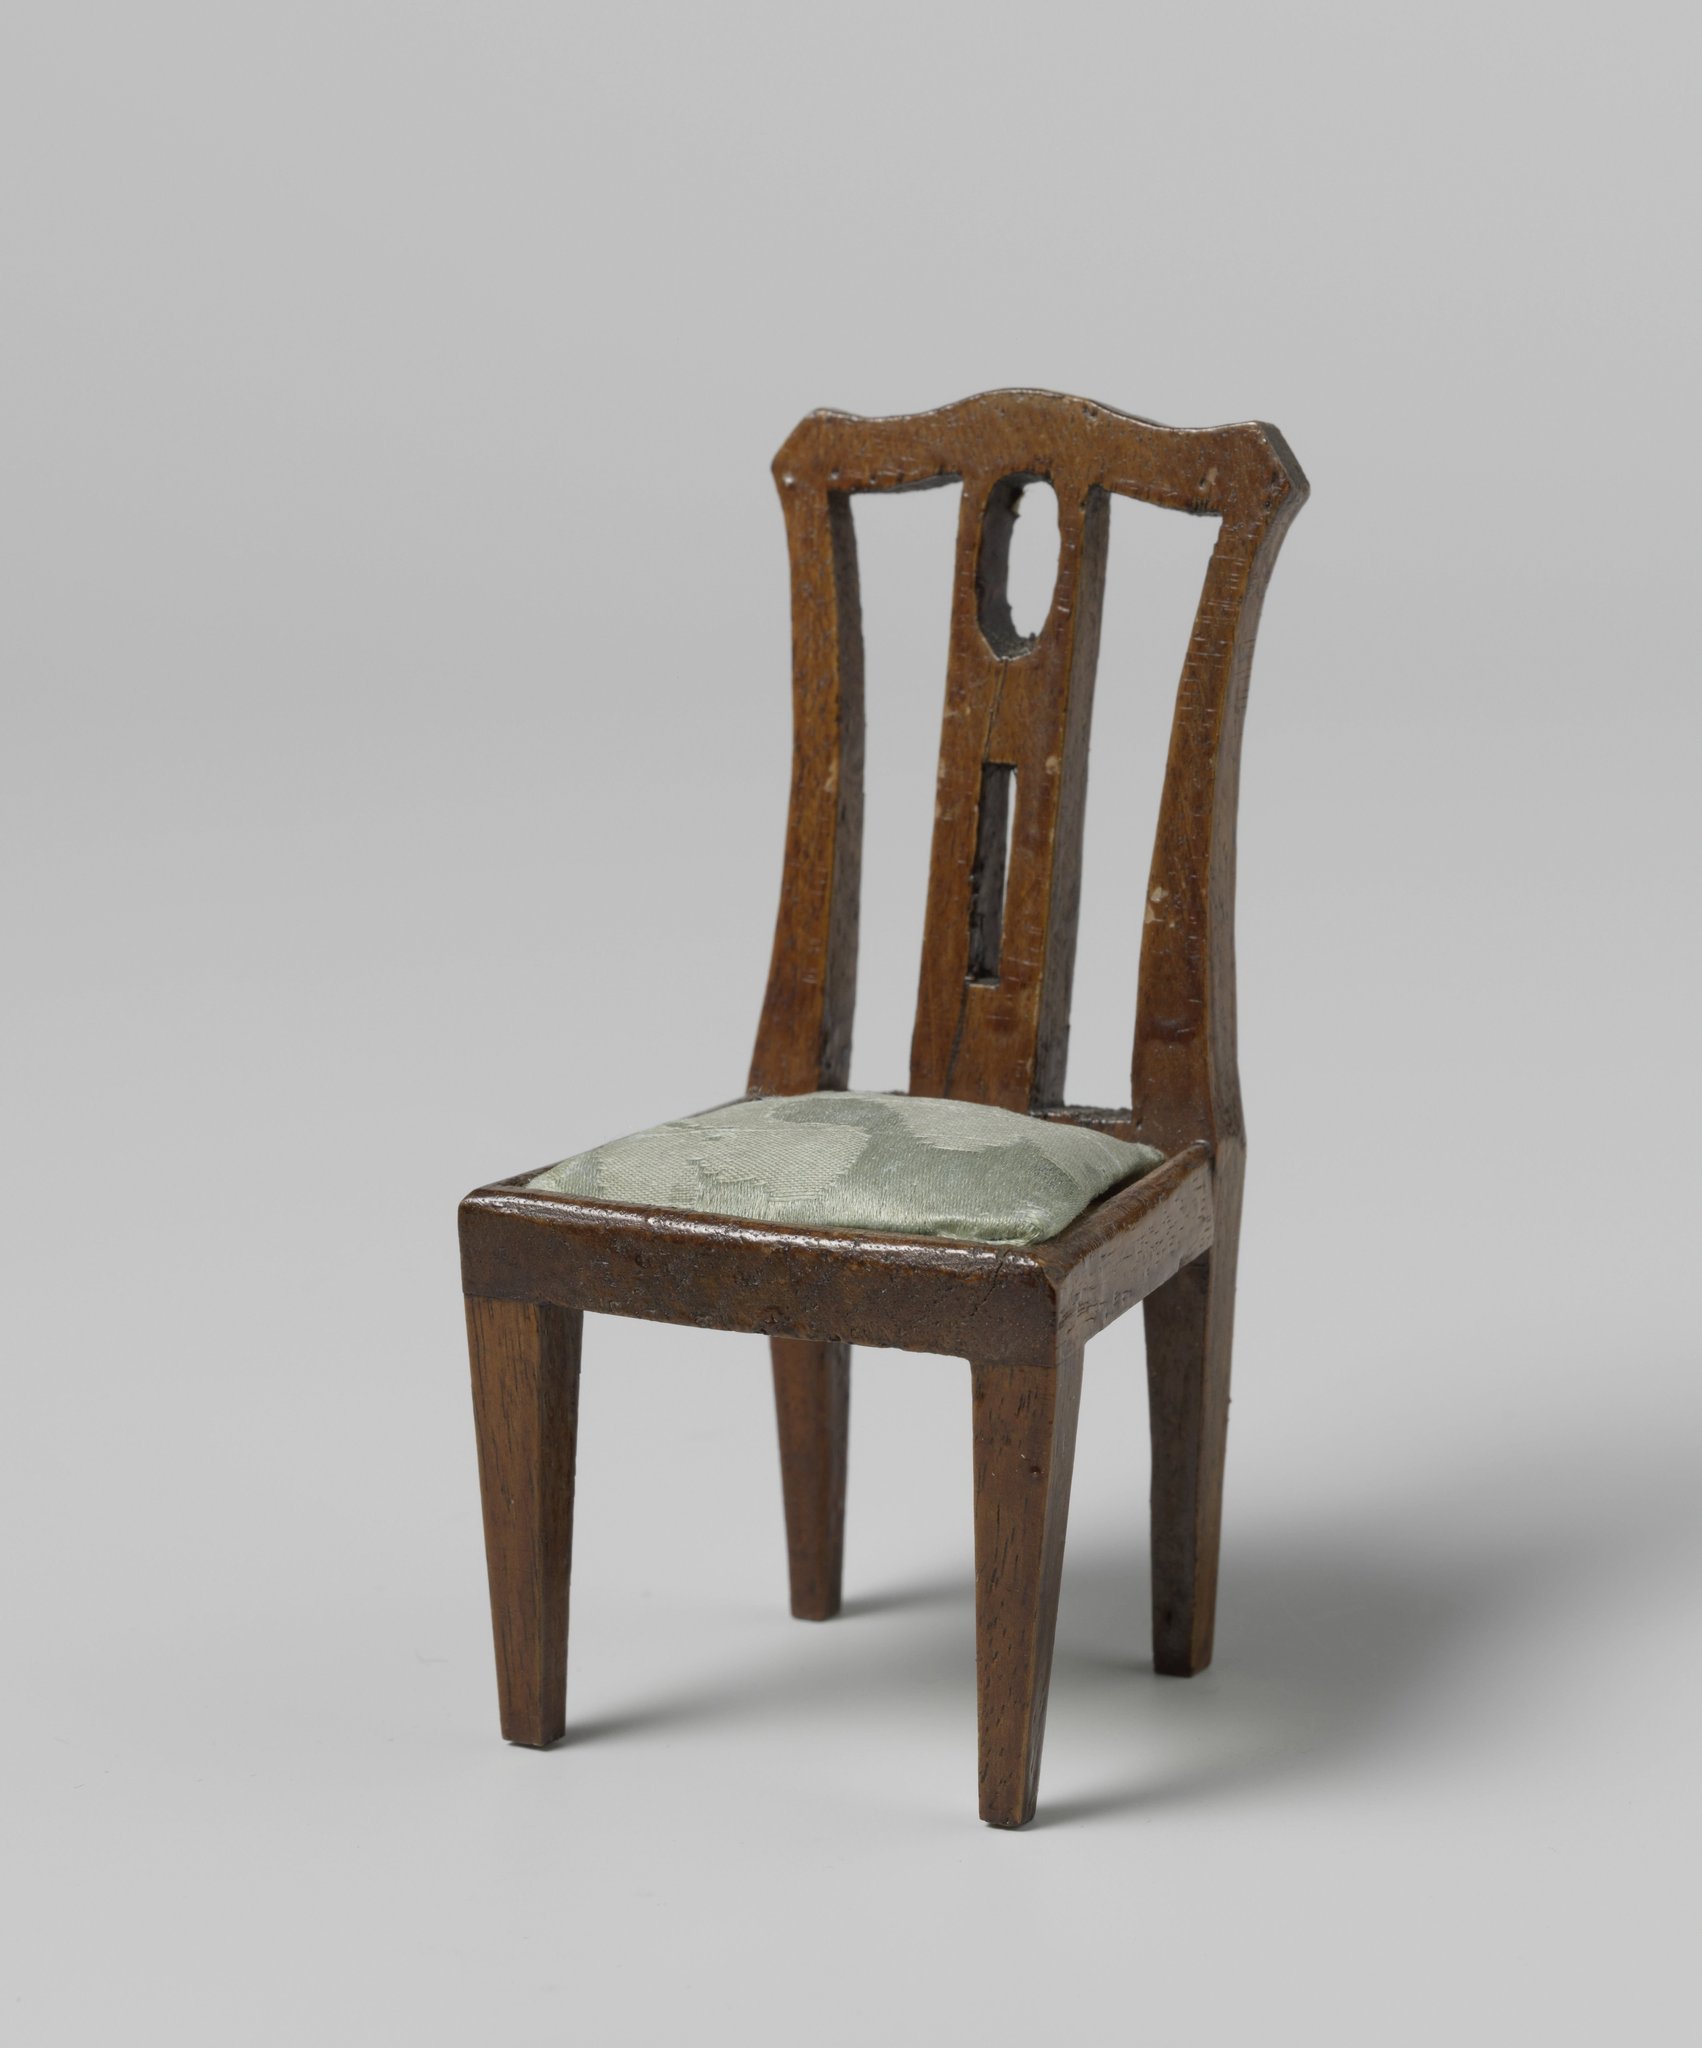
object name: miniature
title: Stoel met blauwe bekleding en rechte rug met opengewerkte middenstijl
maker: Anonymous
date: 1775-1800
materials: cardboard, wood, paper, silk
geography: amsterdam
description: Stoel van mahoniehout met een rechte rug, rechte opengewerkte middenstijl en strakke taps toelopende poten. De losse zitting is bekleed met blauwe zijden damast.